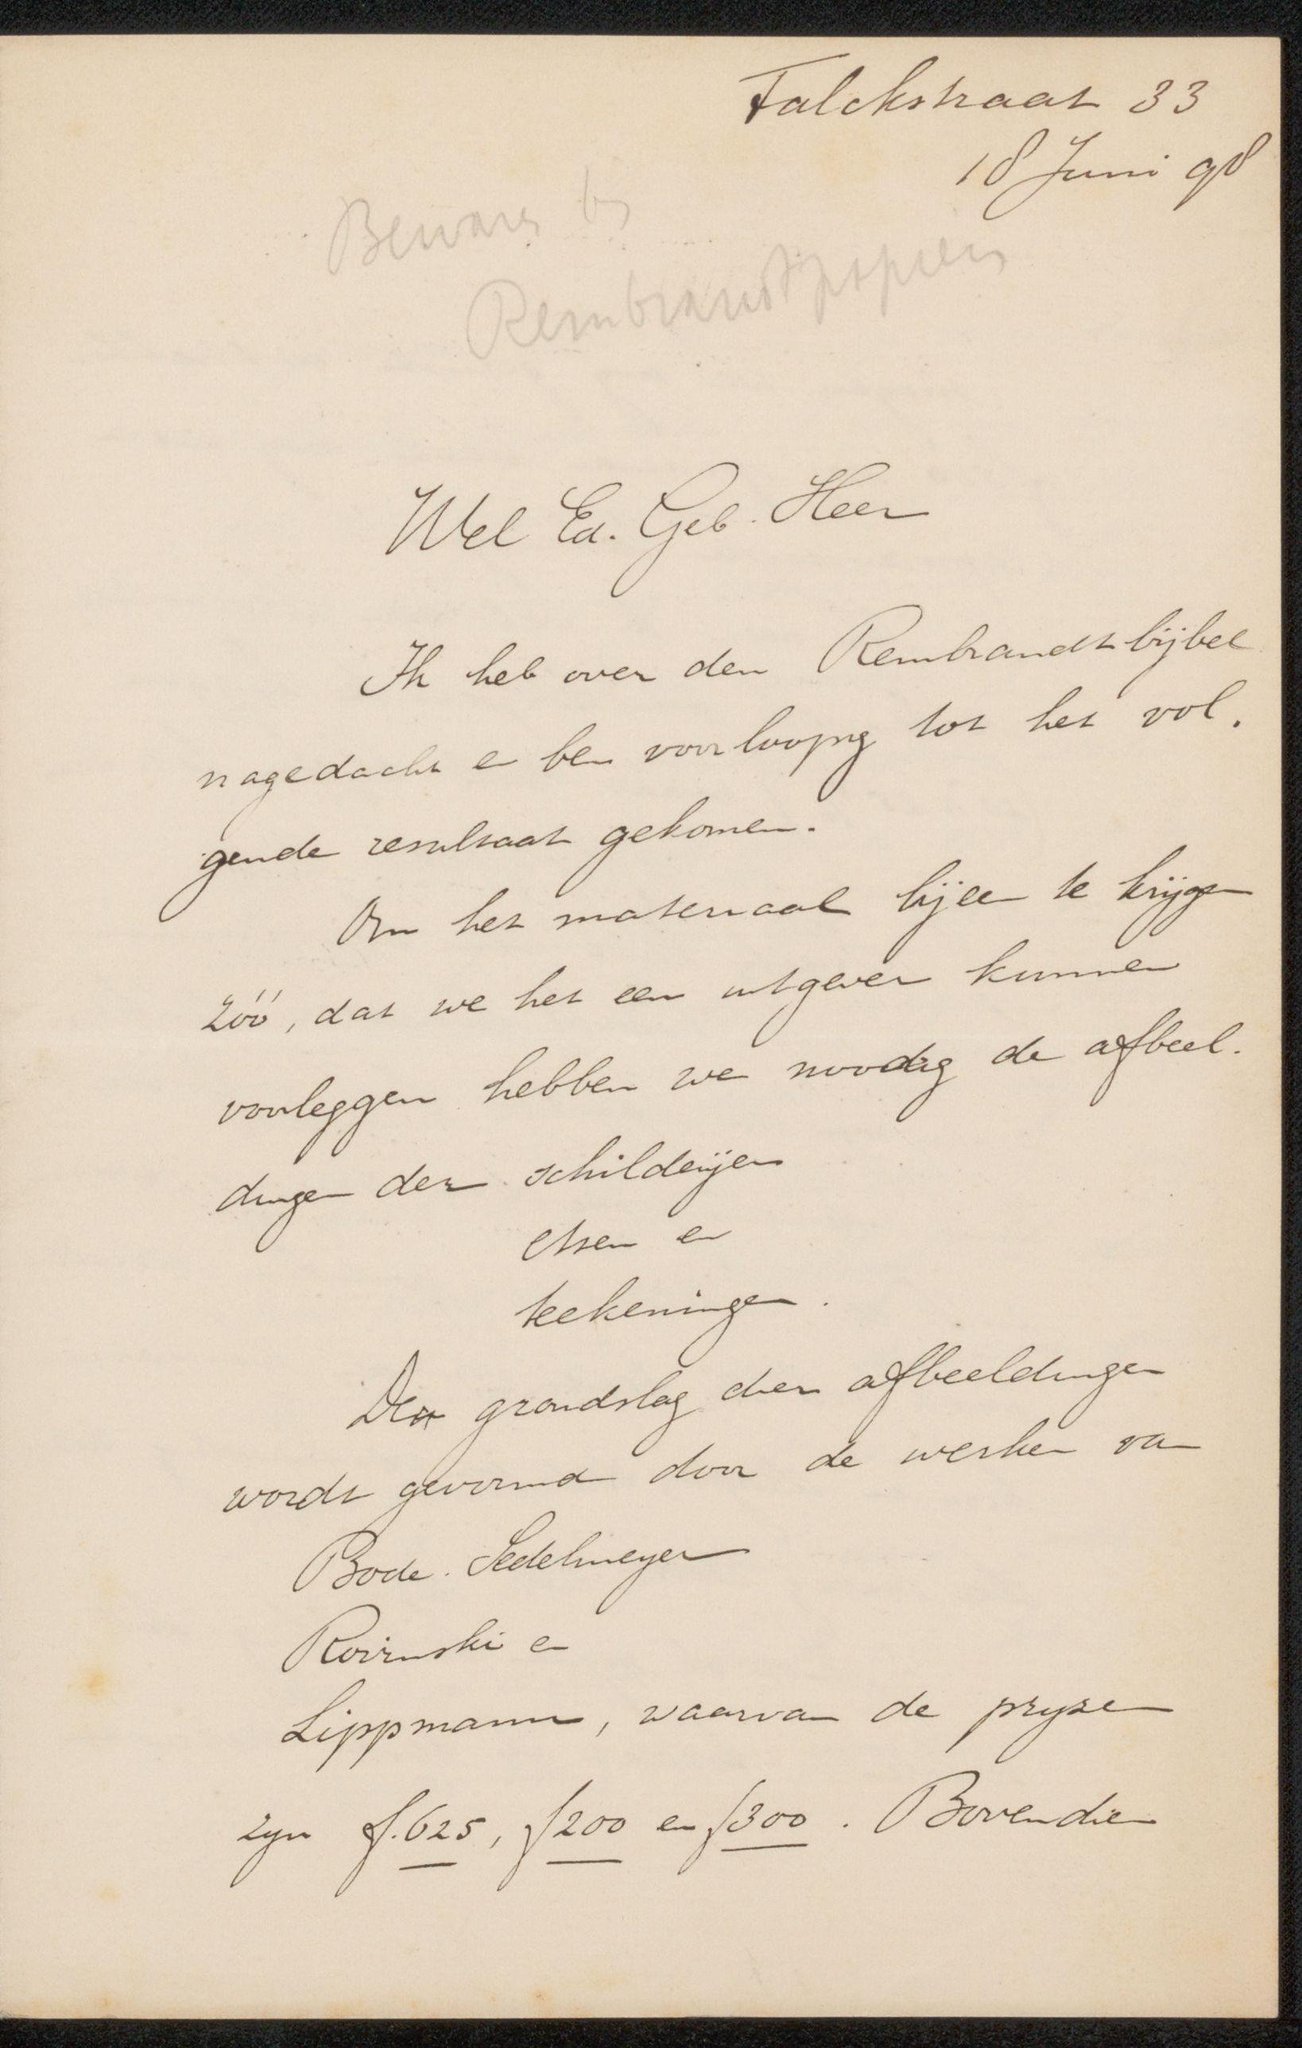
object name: letter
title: Brief aan Jan Veth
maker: cornelis hofstede de groot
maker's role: kunsthistoricus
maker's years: 1863-1940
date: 1898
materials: ink, paper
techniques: pen, writing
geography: amsterdam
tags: dordrecht, designer, jan veth, leiden, amsterdam, painter, print maker, draughtsman, rembrandt van rijn, publisher, charles sedelmeyer, berlin, wilhelm von bode, politician, money, printed matter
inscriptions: collector's mark: ‘RPK’